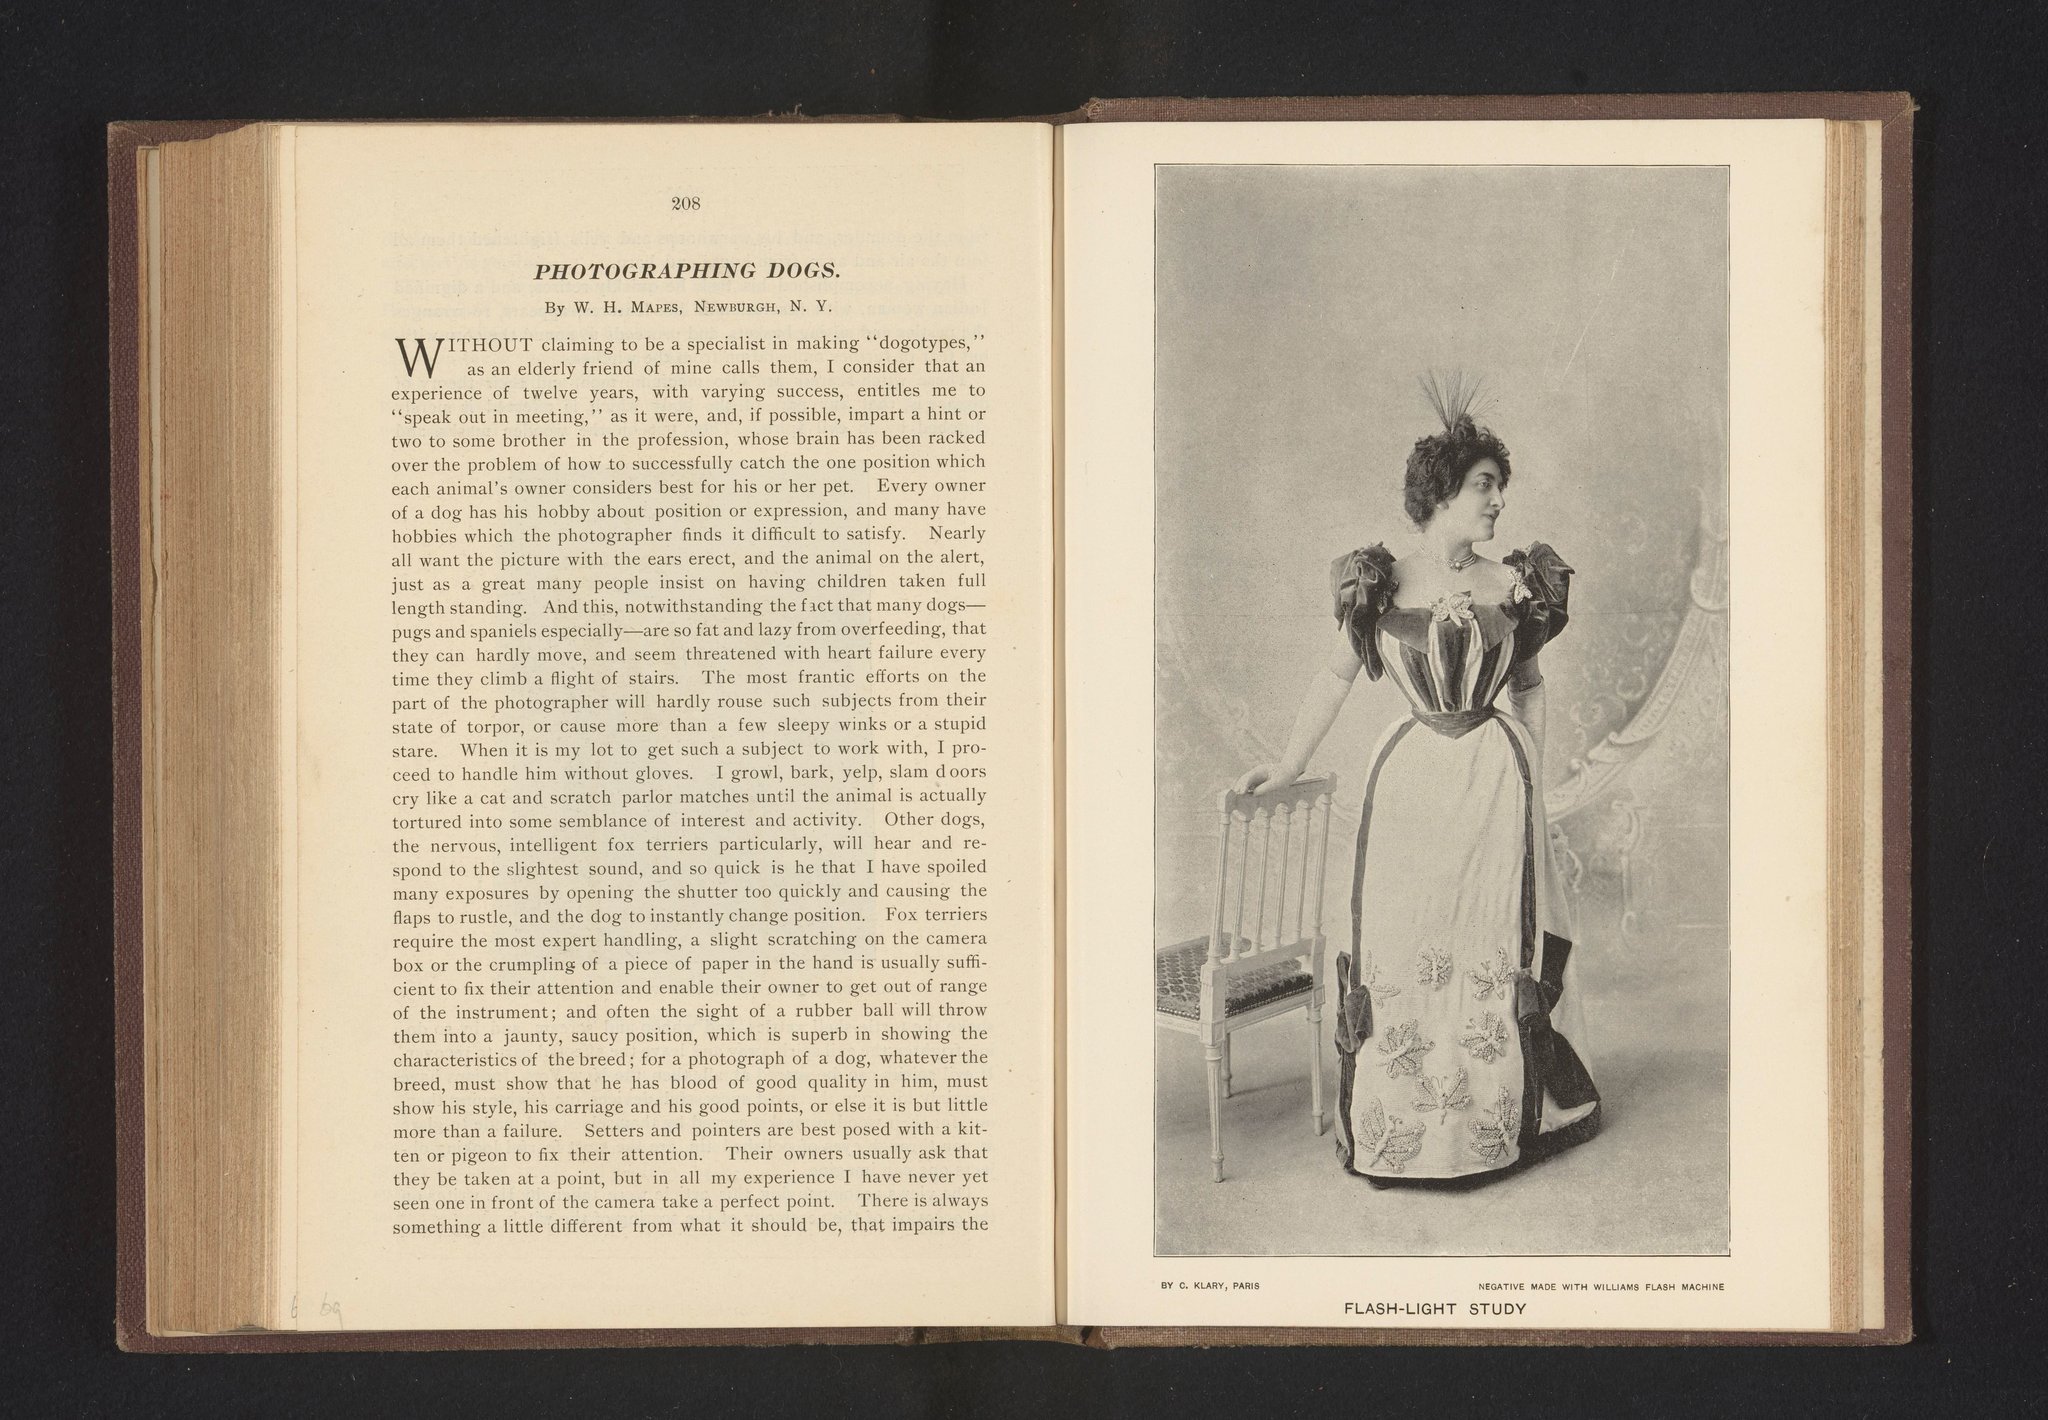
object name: photomechanical print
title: Flash-light study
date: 1890-1895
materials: paper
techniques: autotype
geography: paris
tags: studio ~ photographer, adult woman